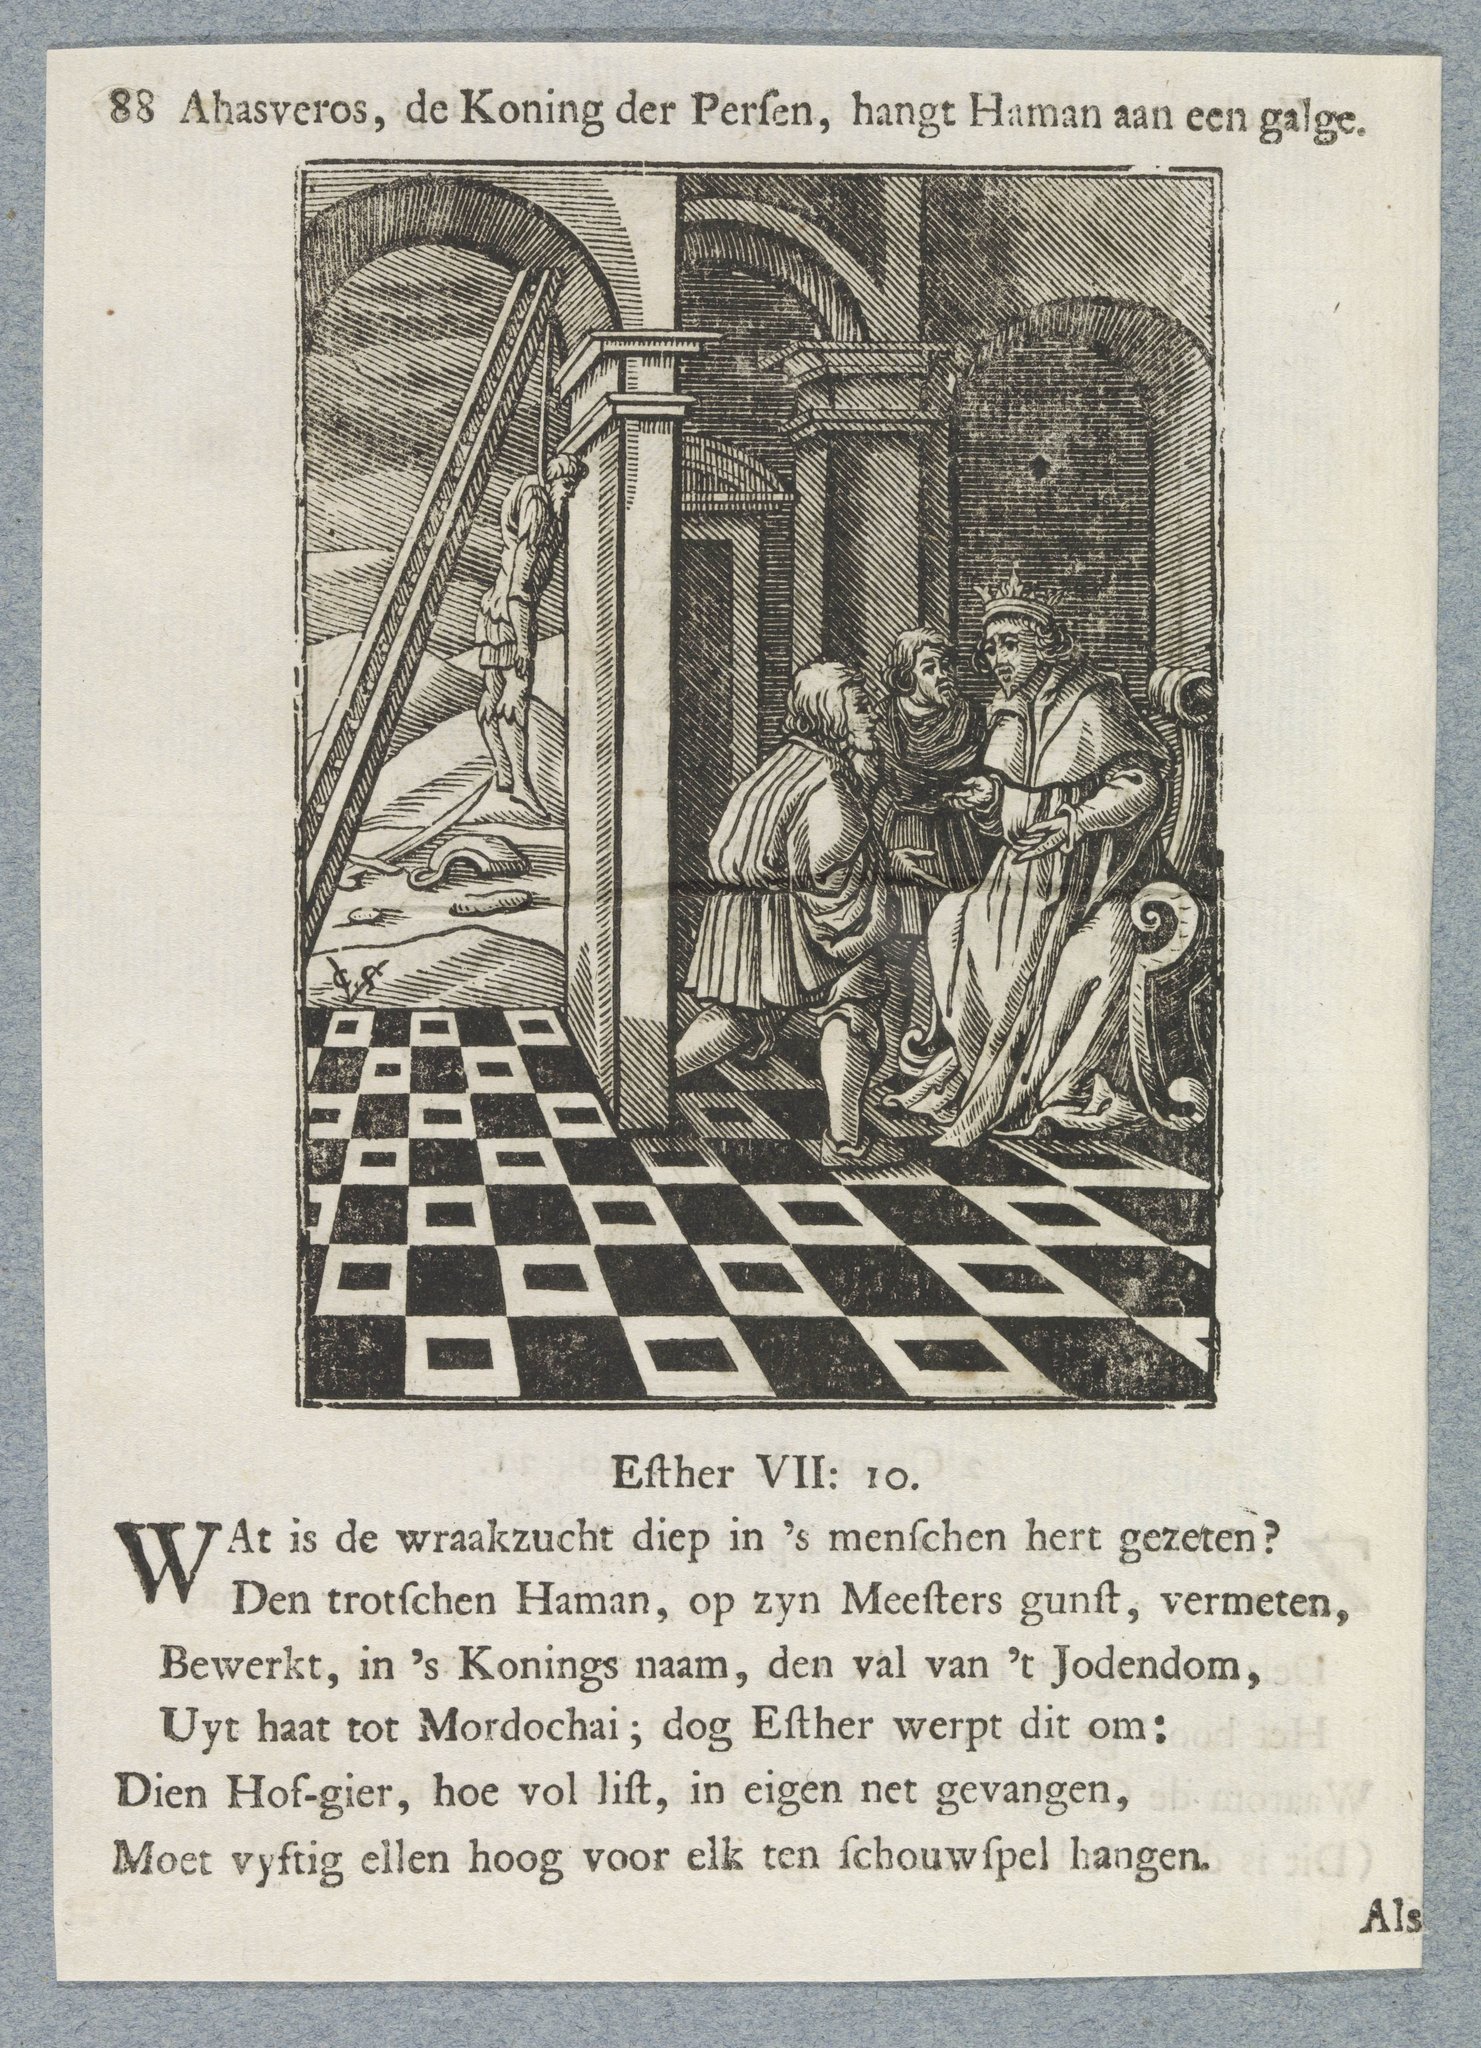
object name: album leaf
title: Ahasveros, de koning der Perzen, hangt Haman aan een galg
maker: jan klooster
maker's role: bookseller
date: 1645-1646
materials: paper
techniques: letterpress printing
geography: amsterdam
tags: haman on the gallows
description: De prent is afkomstig uit: Bybels Lusthof. Amsterdam, J. Klooster, 1740. De prent werd gemaakt voor de uitgaven van P.J. Paets uit Amsterdam. Ze komt in ieder geval voor in: Bibels Tresoor ofte der zielen lusthof. Amsterdam, P.J. Paets, 1646. Mogelijk staat ze ook in: Historien ende Prophetien. [Amsterdam], P.J. Paets, 1645.